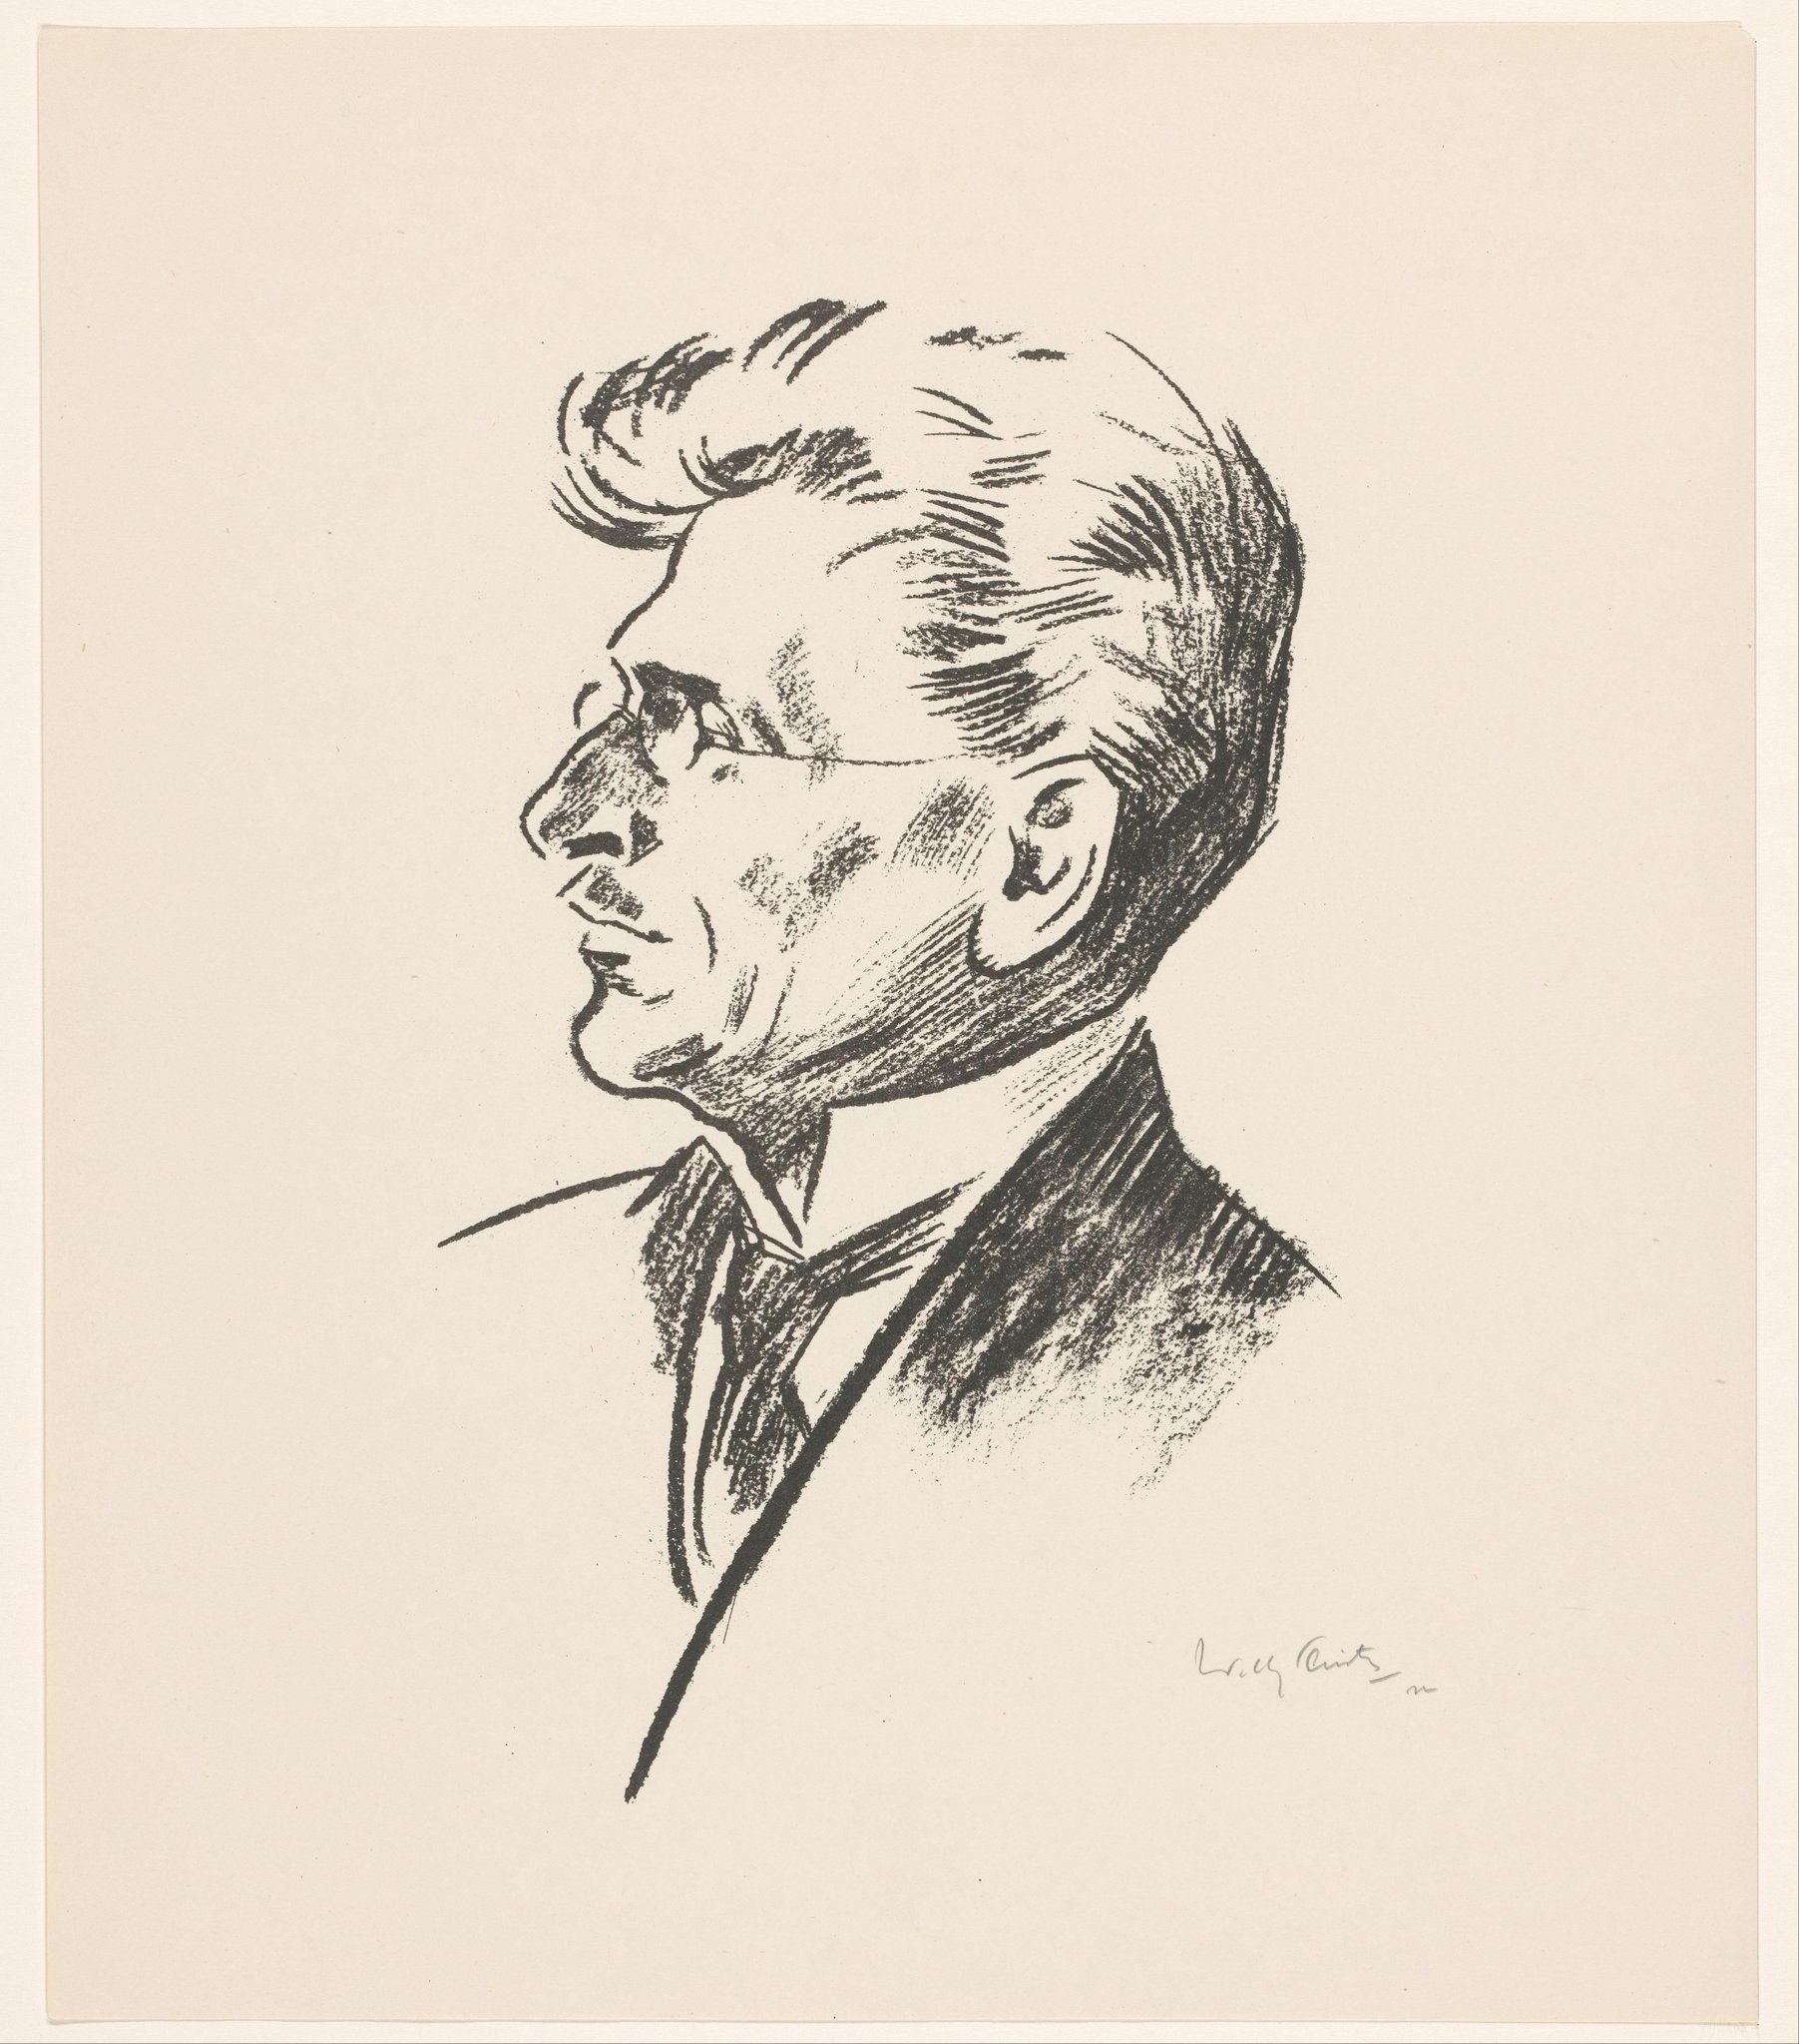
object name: print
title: Portret van E. Bonebakker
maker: willy sluiter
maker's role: draughtsman, painter, print maker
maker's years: 1873-1949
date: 1922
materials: paper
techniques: lithograph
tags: historical persons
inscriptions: collector's mark: Lugt 2228